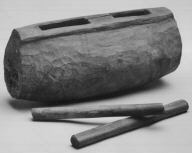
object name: m'kul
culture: fang people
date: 1867-1900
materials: wood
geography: gabon